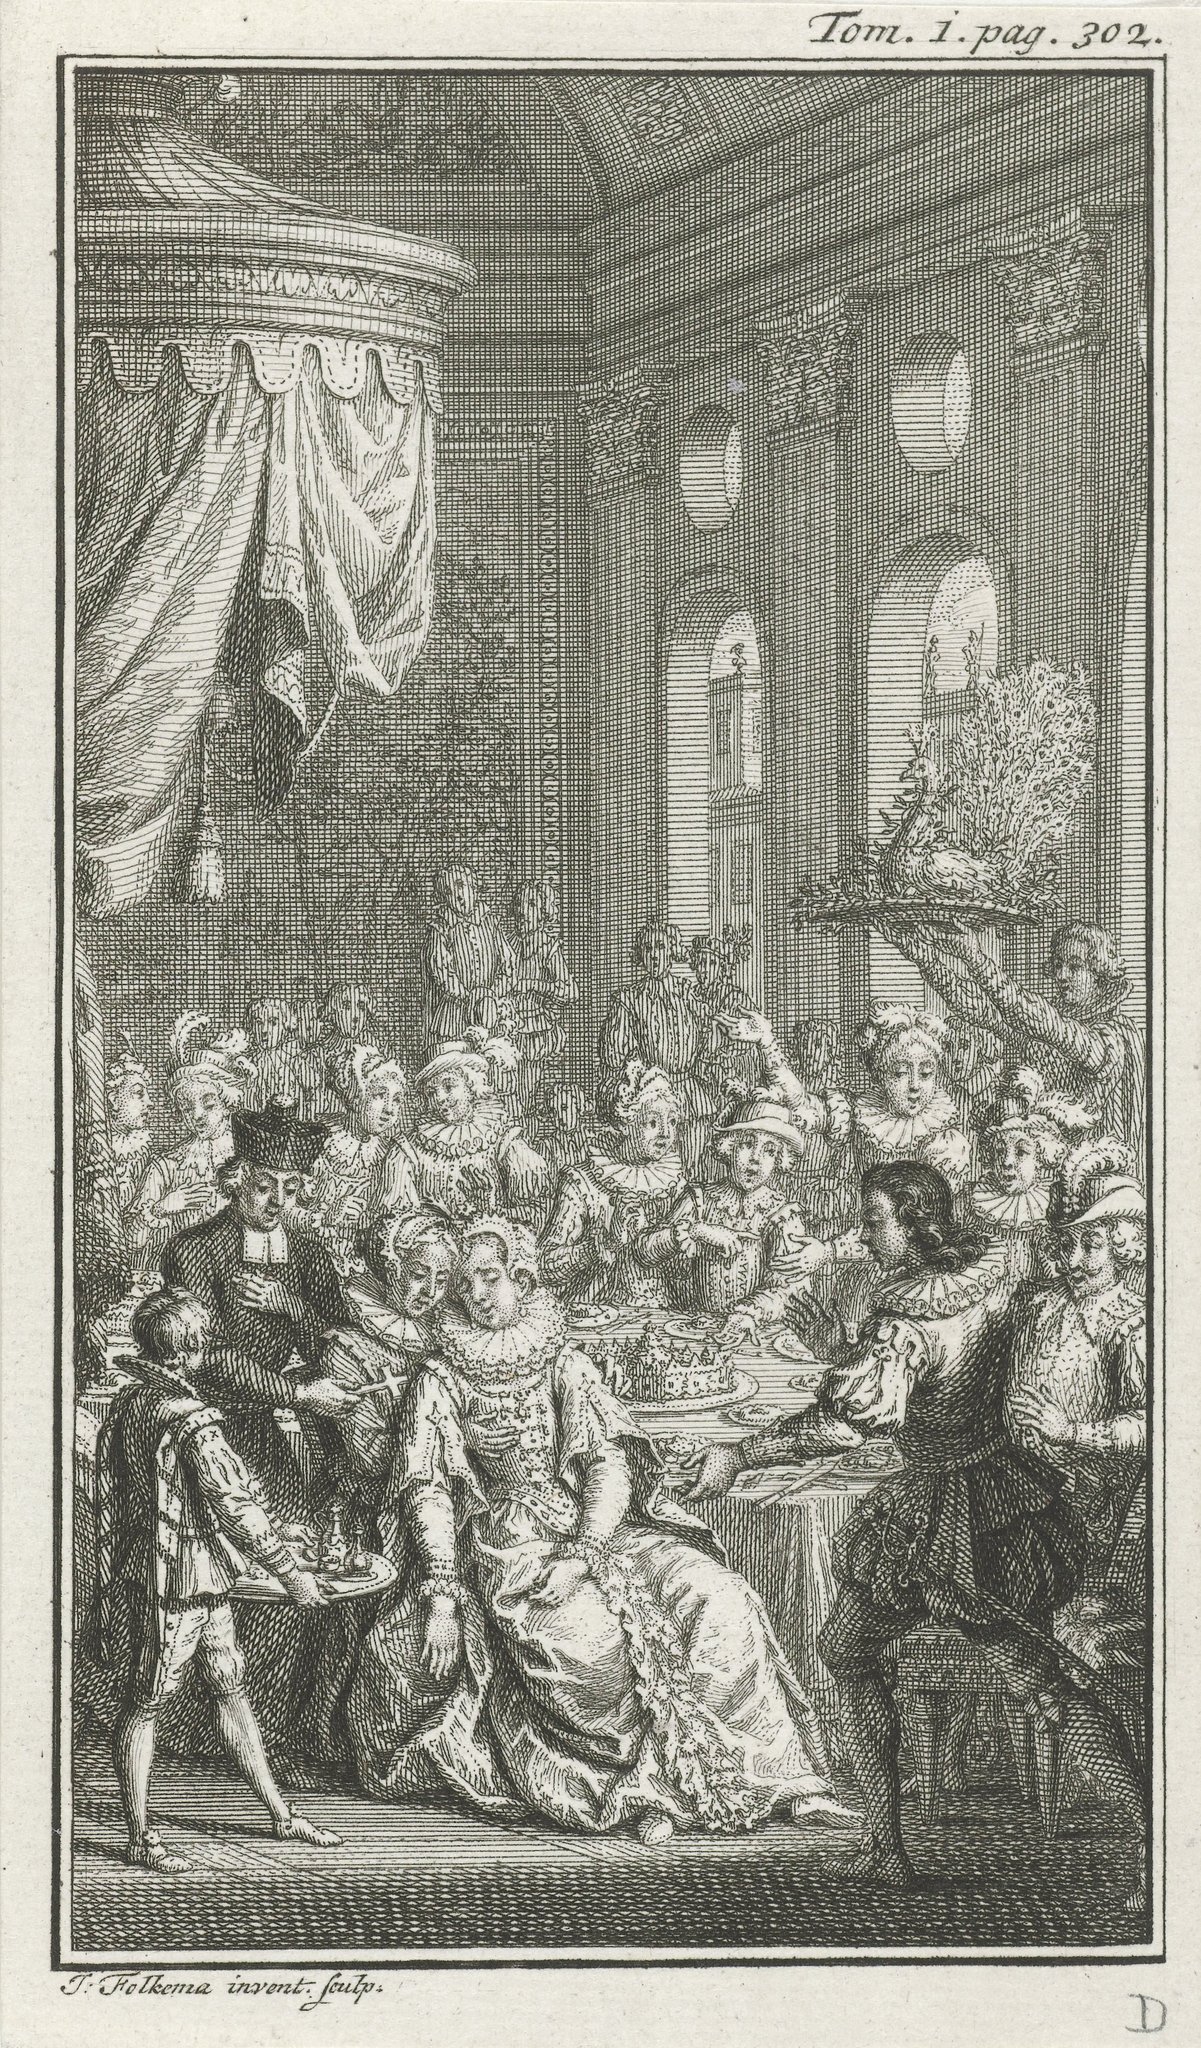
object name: book illustration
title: Gezelschap aan een banket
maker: jacob folkema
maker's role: draughtsman, print maker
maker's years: 1692-1767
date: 1702-1767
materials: paper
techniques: etching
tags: fainting, swooning, celebration meal, feast, banquet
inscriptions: collector's mark: Lugt 240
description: In een rijk gedecoreerde zaal zit een gezelschap aan een feestelijk banket. Op een grote schaal wordt een pauw opgediend. Een geestelijke ontfermt zich op de voorgrond over een onwel geworden vrouw. Rechts schieten twee mannen te hulp. Prent rechtsboven gemerkt: Tom. i. pag. 302.